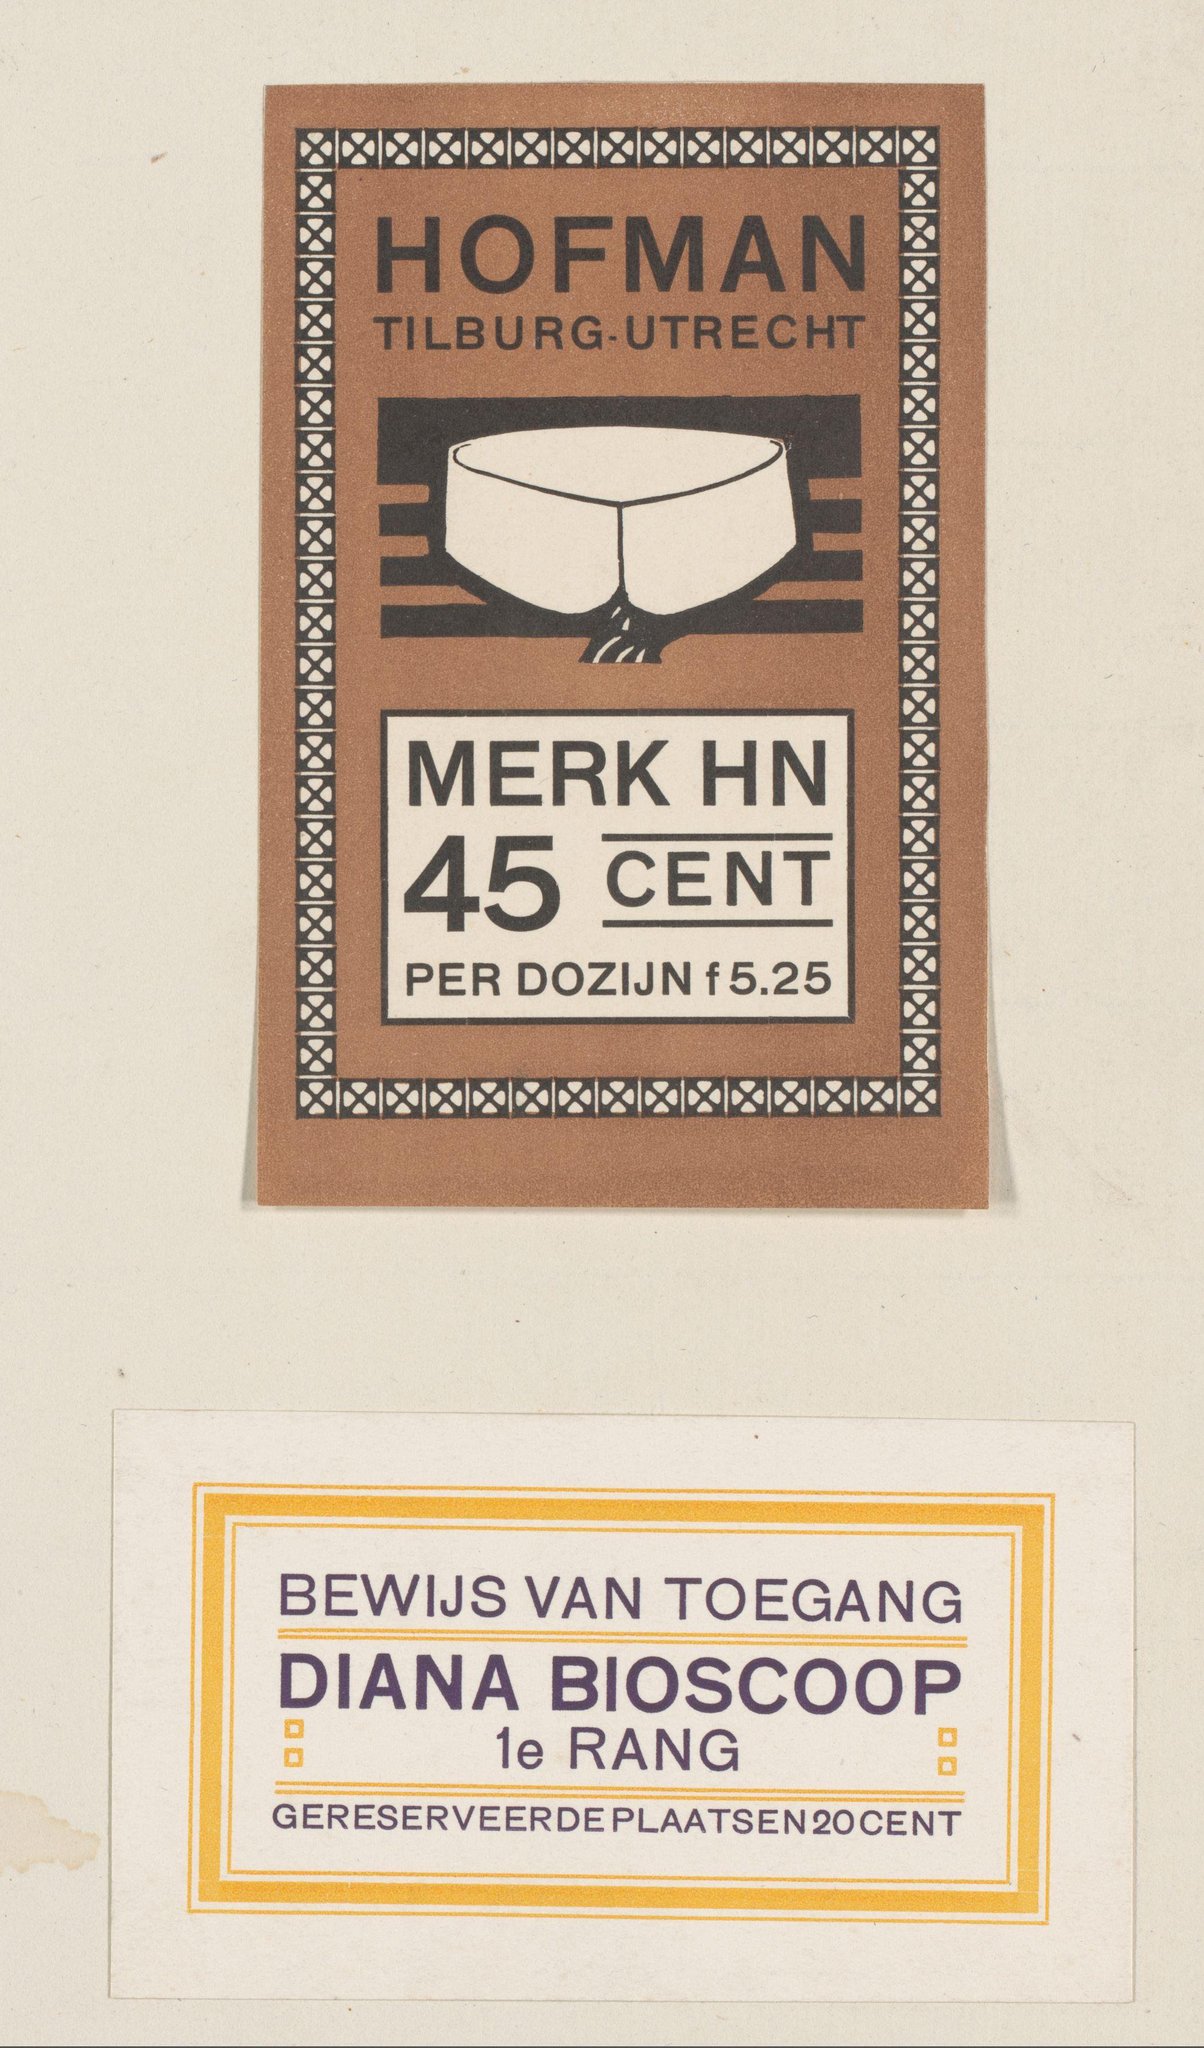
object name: photomechanical print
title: Advertentie van Hofman en een toegangsbewijs voor de Diana Bioscoop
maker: reinier willem petrus de vries (1874-1953)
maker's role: draughtsman, print maker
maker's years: 1874-1953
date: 1884-1952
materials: paper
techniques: printing block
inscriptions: annotation: ‘de V’